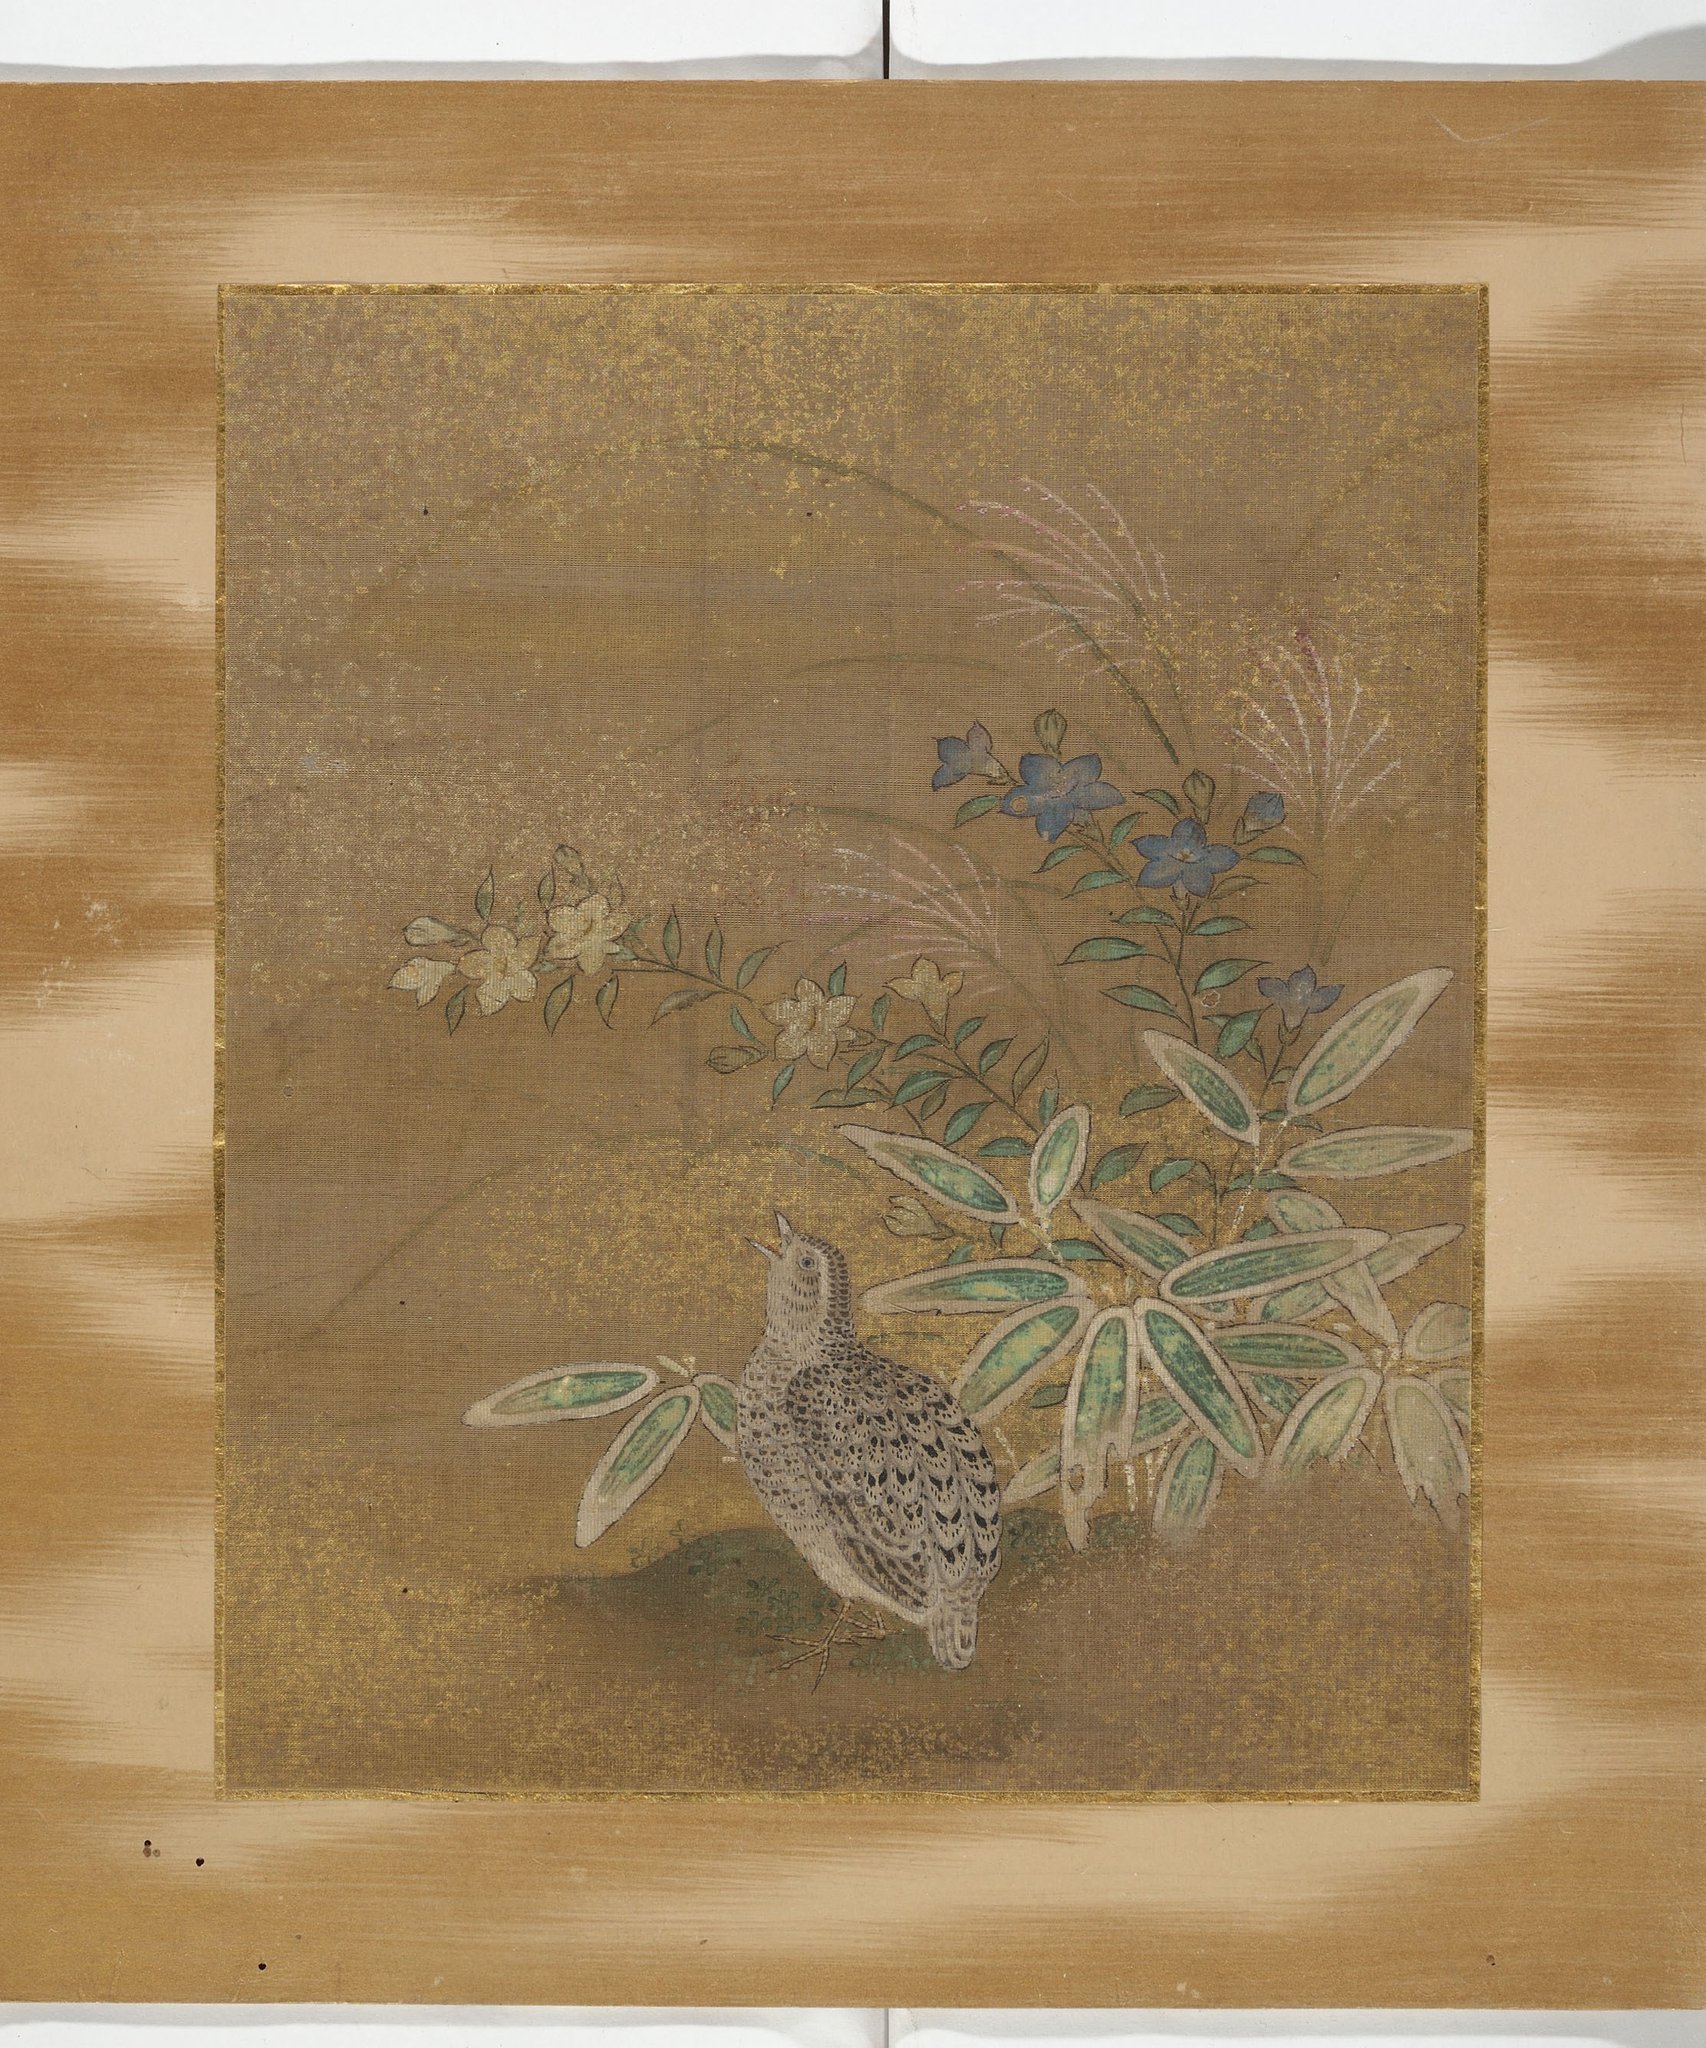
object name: illustrated book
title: Album of Birds and Flowers and Other Subjects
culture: japanese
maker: tosa mitsunari 土佐光成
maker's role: artist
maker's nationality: japanese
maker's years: 1646-1710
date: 1667-1700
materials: ink, silk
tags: birds,flowers